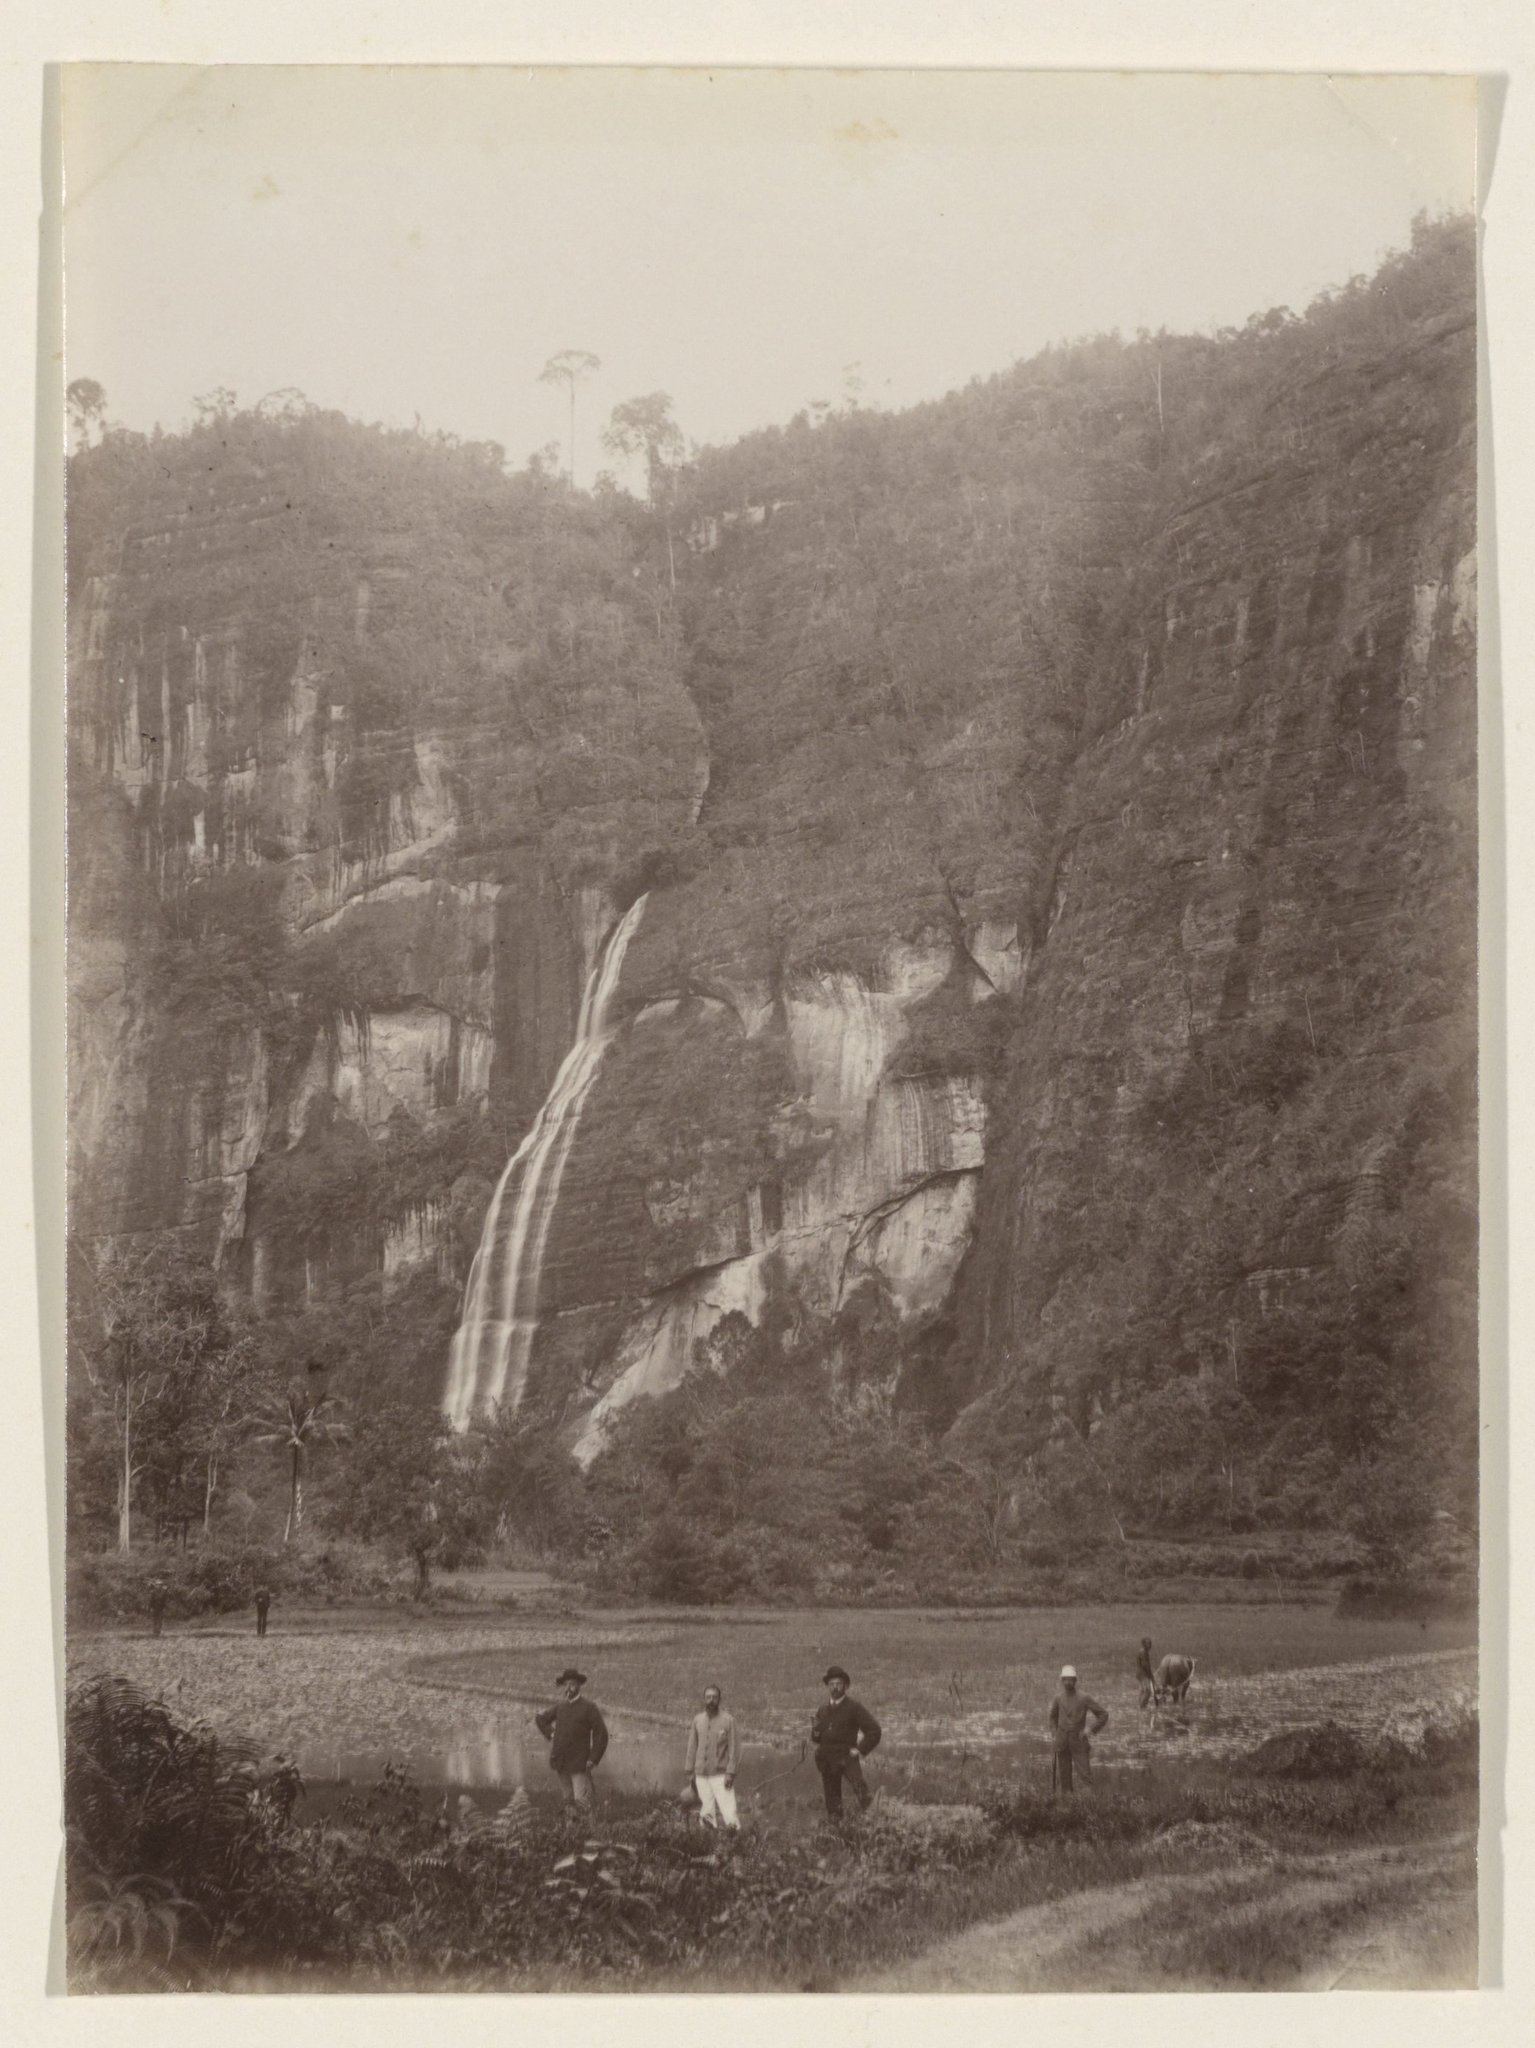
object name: photograph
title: Mannen in een akker in Nederlands-Indië met op de achtergrond een waterval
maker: Anonymous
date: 1860-1900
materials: paper, photographic support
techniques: albumen print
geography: dutch east indies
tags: waterfall, dutch east indies, the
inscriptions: inscription: ‘Waterval in de kloof Aron.’, inscription: ‘Waterval in de kloof van Aron.’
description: Onderdeel van Fotoalbum van een reis door de Verenigde Staten, Honolulu, Nederlands-Indië, Aden, Zanzibar en Zuidelijk Afrika.